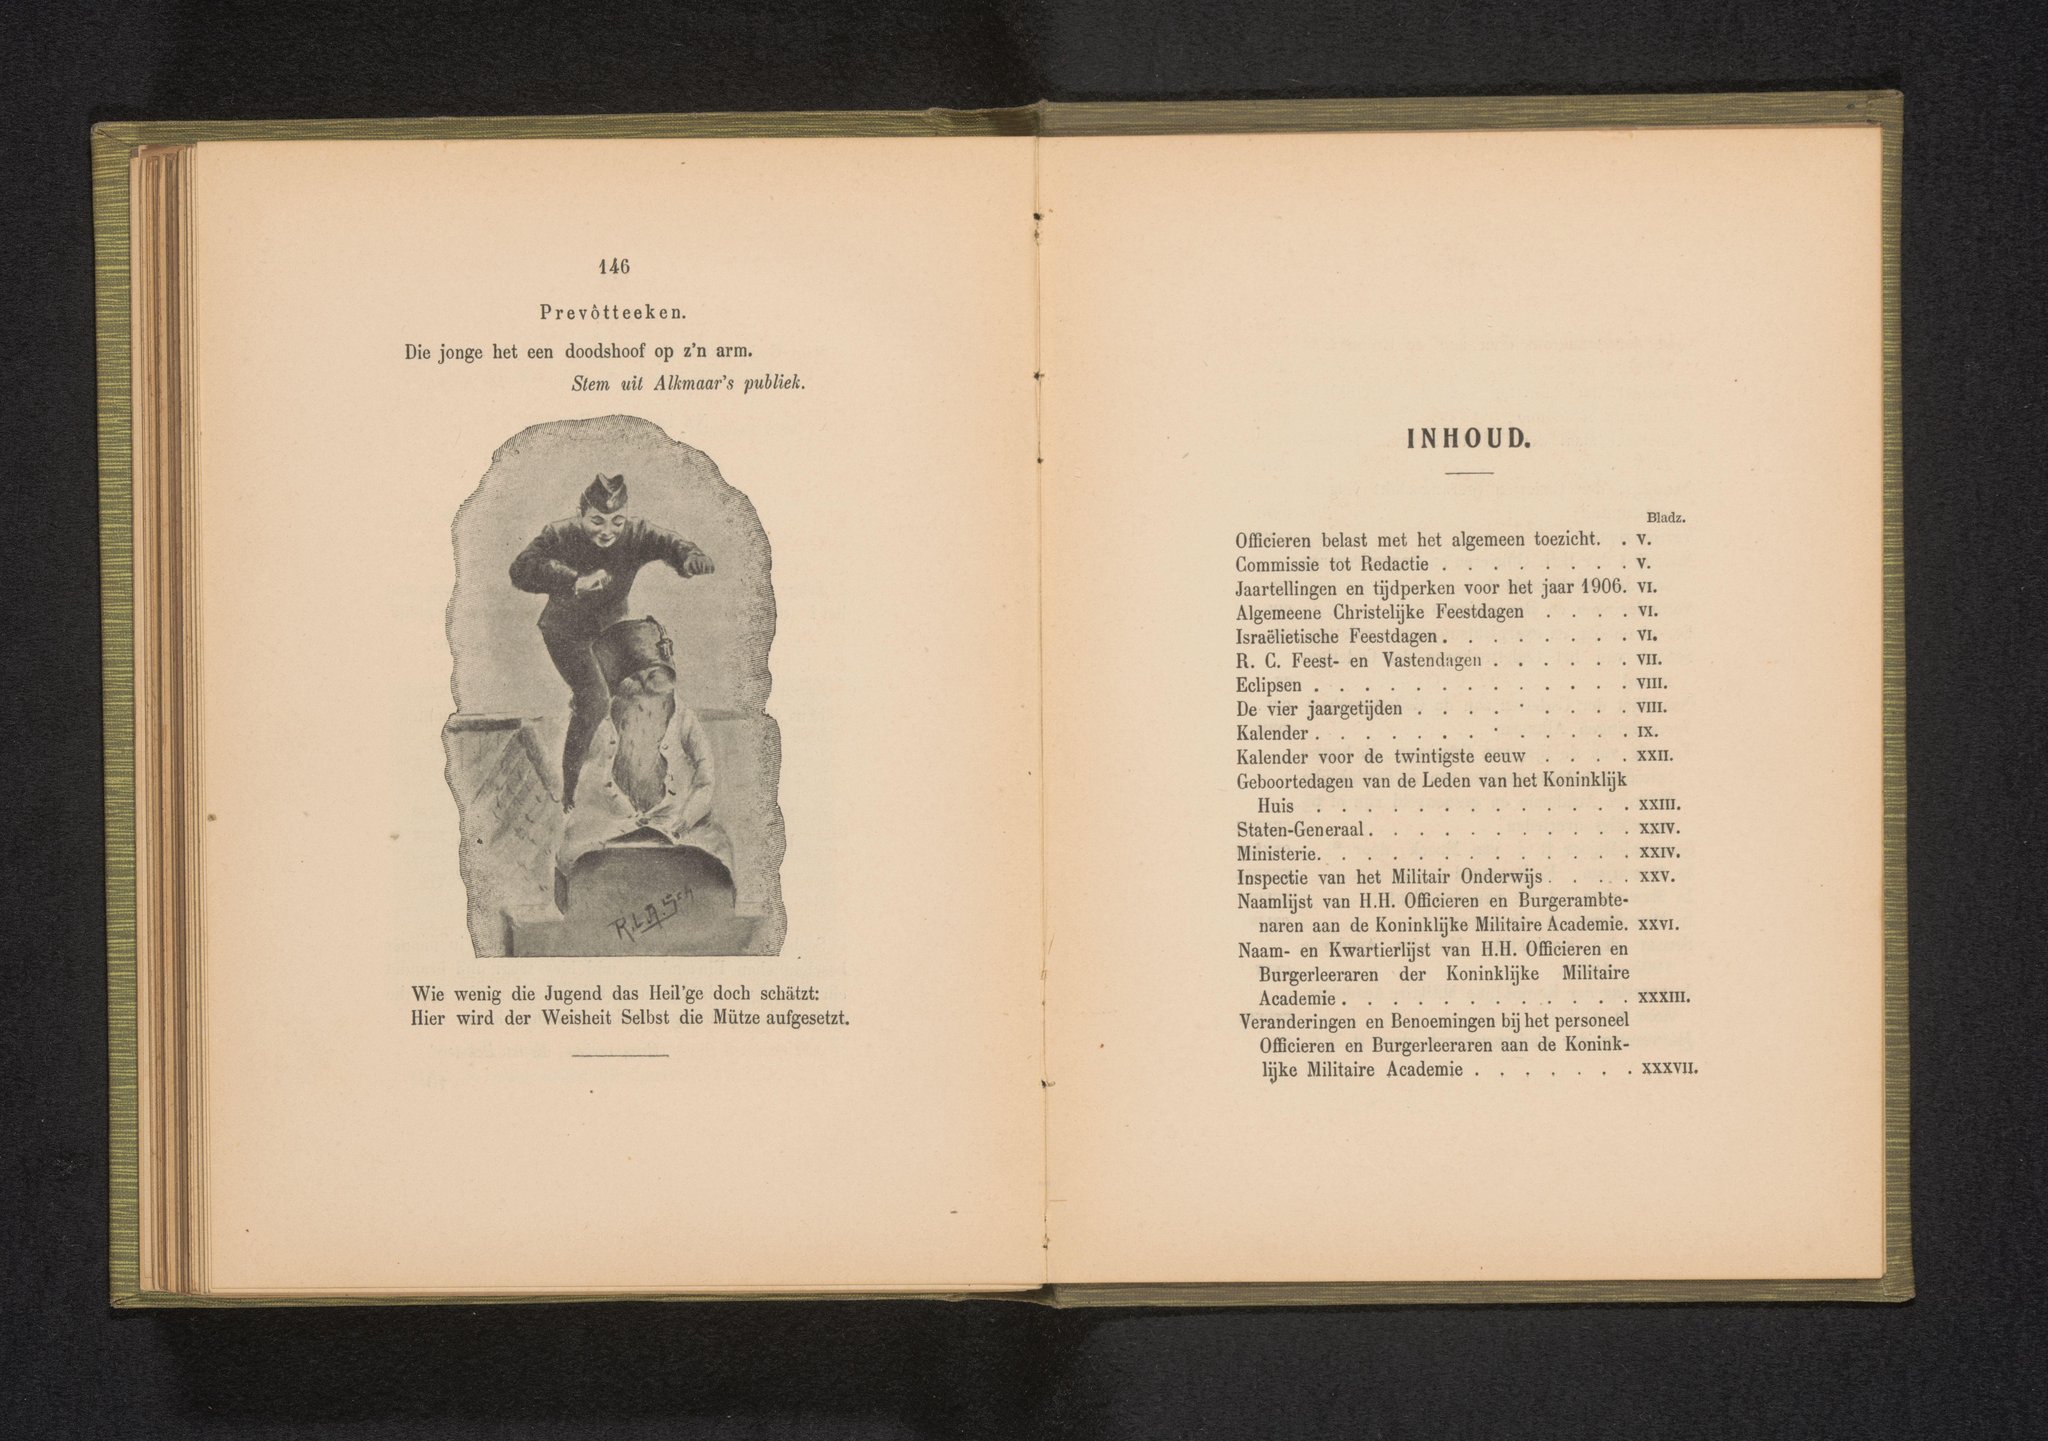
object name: page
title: Reproductie van een tekening van een jongen die een personificatie van wijsheid een hoed opzet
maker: Anonymous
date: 1901-1906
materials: paper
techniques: autotype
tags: wisdom; 'sapienza', 'sapienza humana', 'sapienza vera' (ripa) (+ personification), youth, adolescent, head-gear: hat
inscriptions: monogram: ‘R. L.A.Sch’